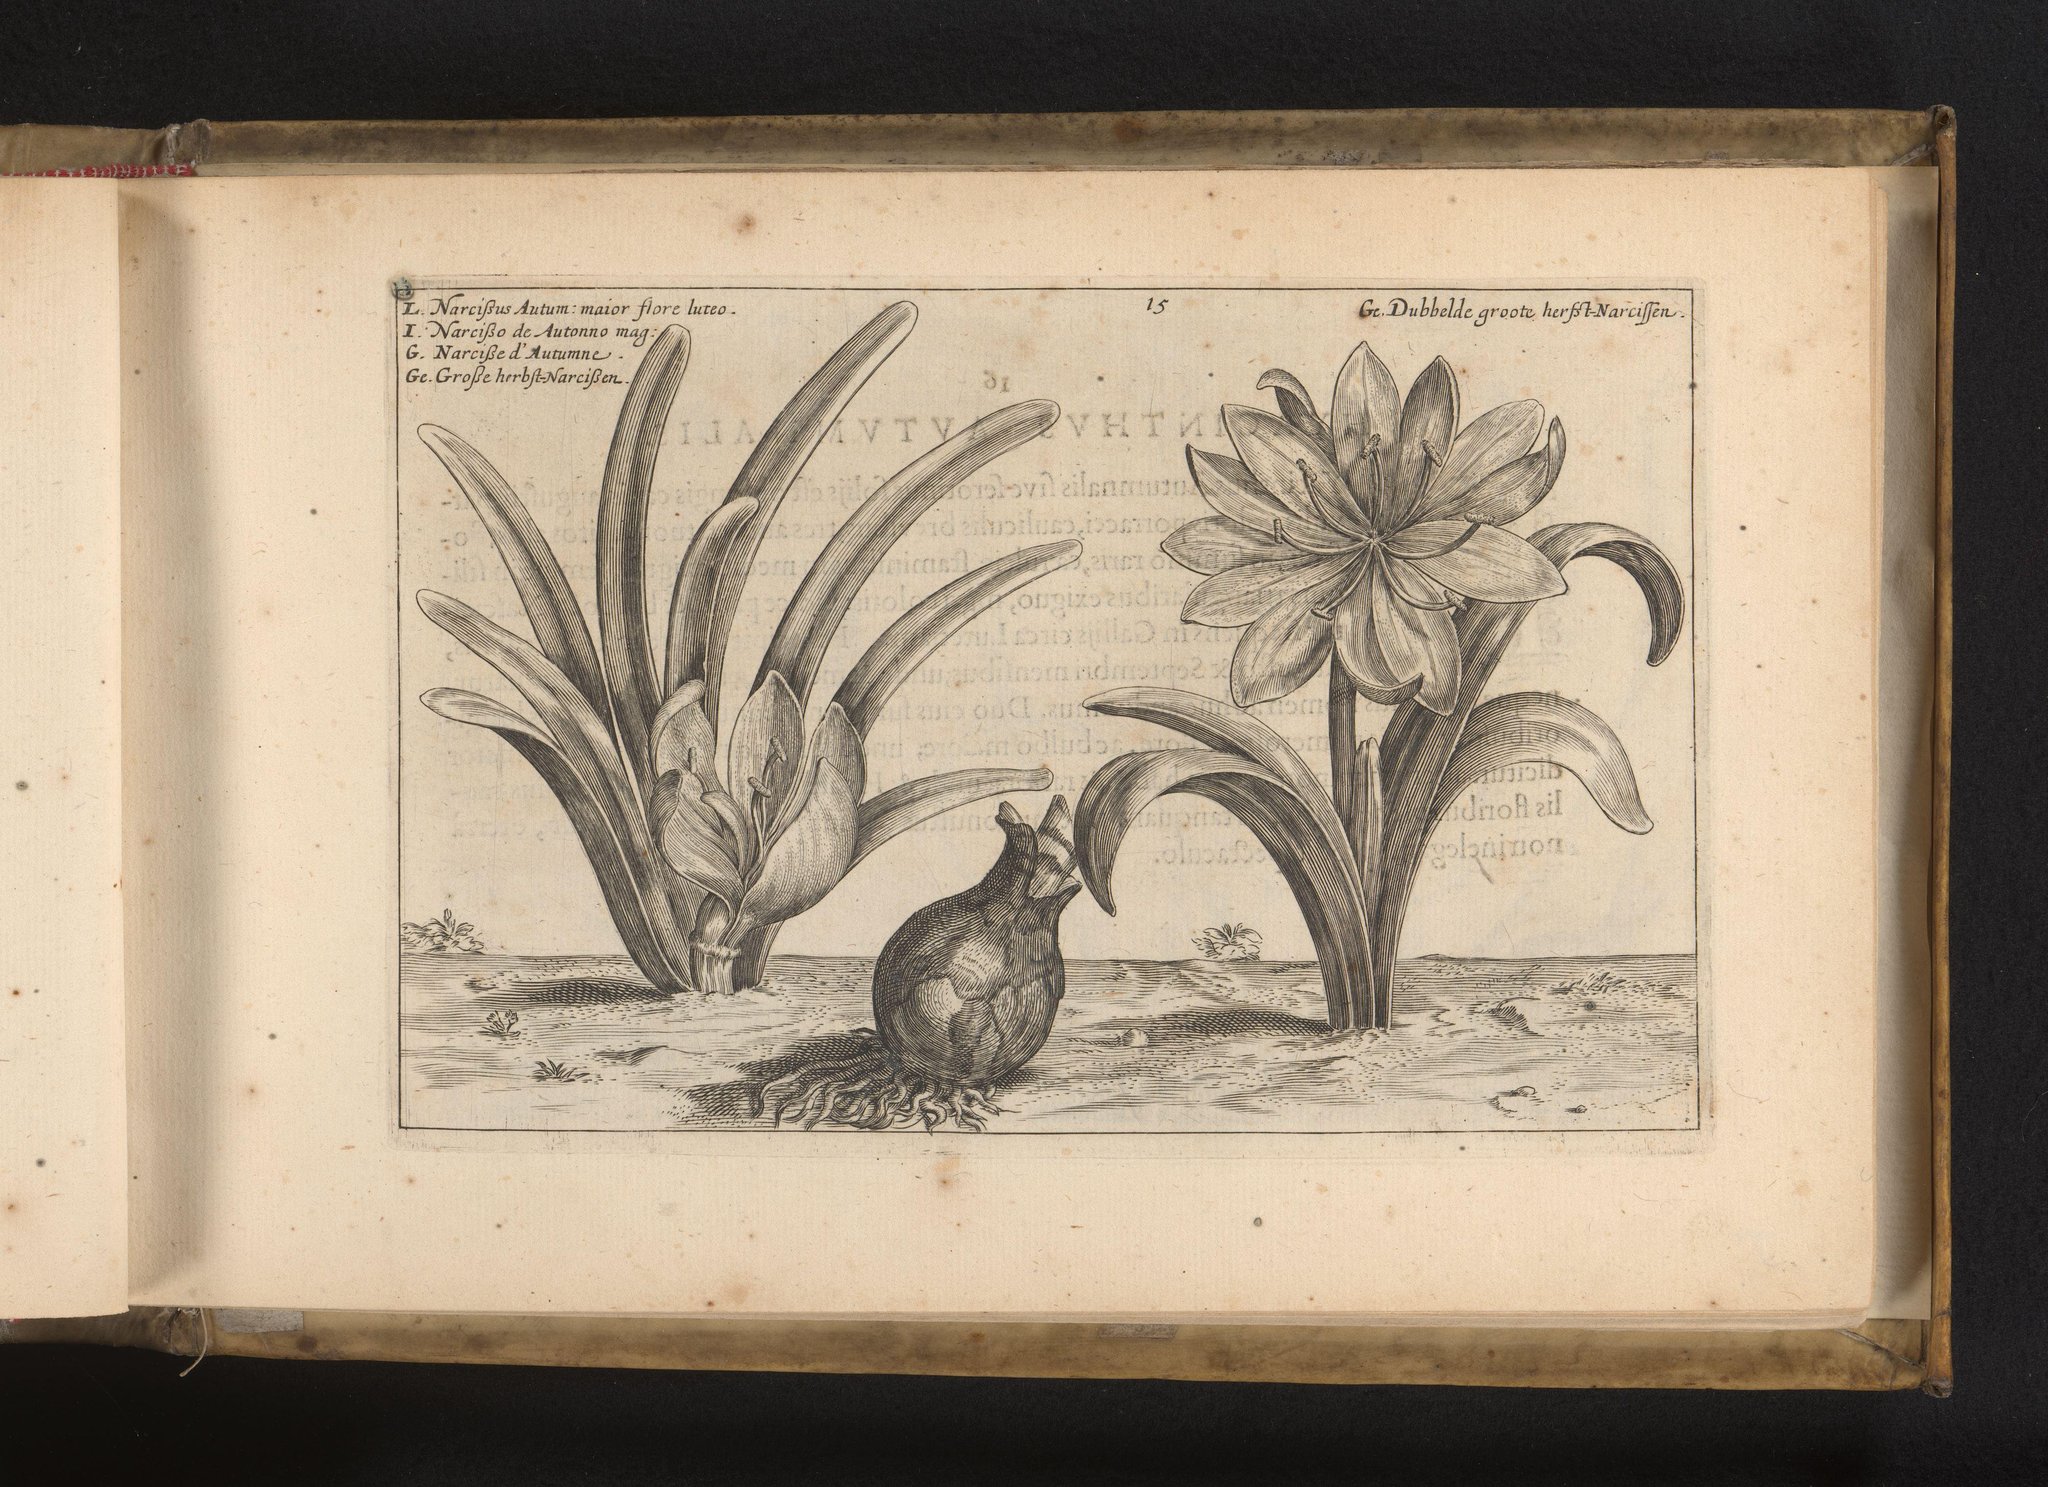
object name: book illustration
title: Narcissus autum. maior flore luteo / [...] Dubbelde groote herst-narcissen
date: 1617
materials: paper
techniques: engraving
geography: utrecht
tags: flowers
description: Prent uit: Passe, Crispijn van de (II). Hortus floridus in quo rariorum & minus vulgarium florum icones ad vivam veramque formam. Arnhem: Johannes Janssonius, 1617.